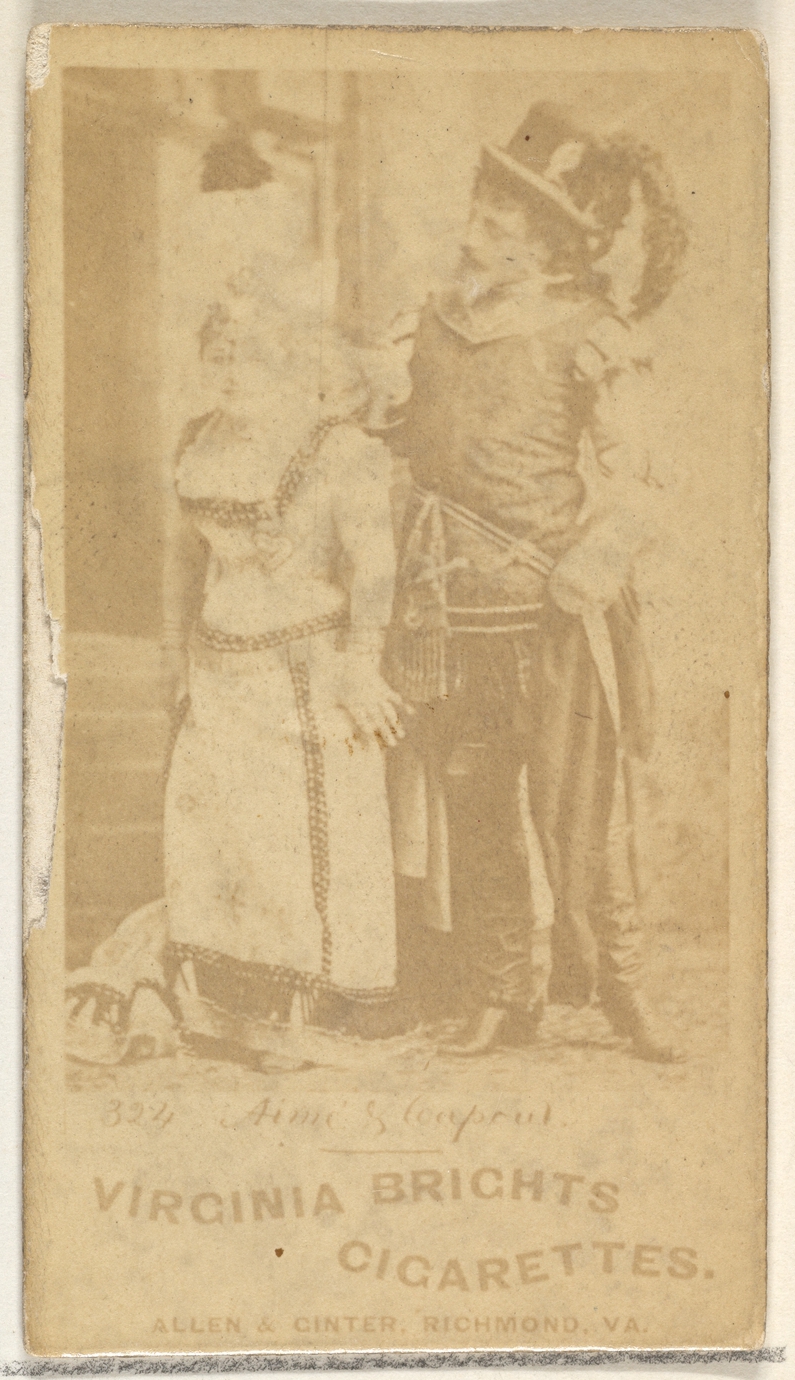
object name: photograph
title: Card 324, Aimi Gloryprint, from the Actors and Actresses series (N45, Type 1) for Virginia Brights Cigarettes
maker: allen & ginter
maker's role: publisher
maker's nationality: american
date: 1888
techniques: albumen silver print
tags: men,portraits,women,actors,actresses